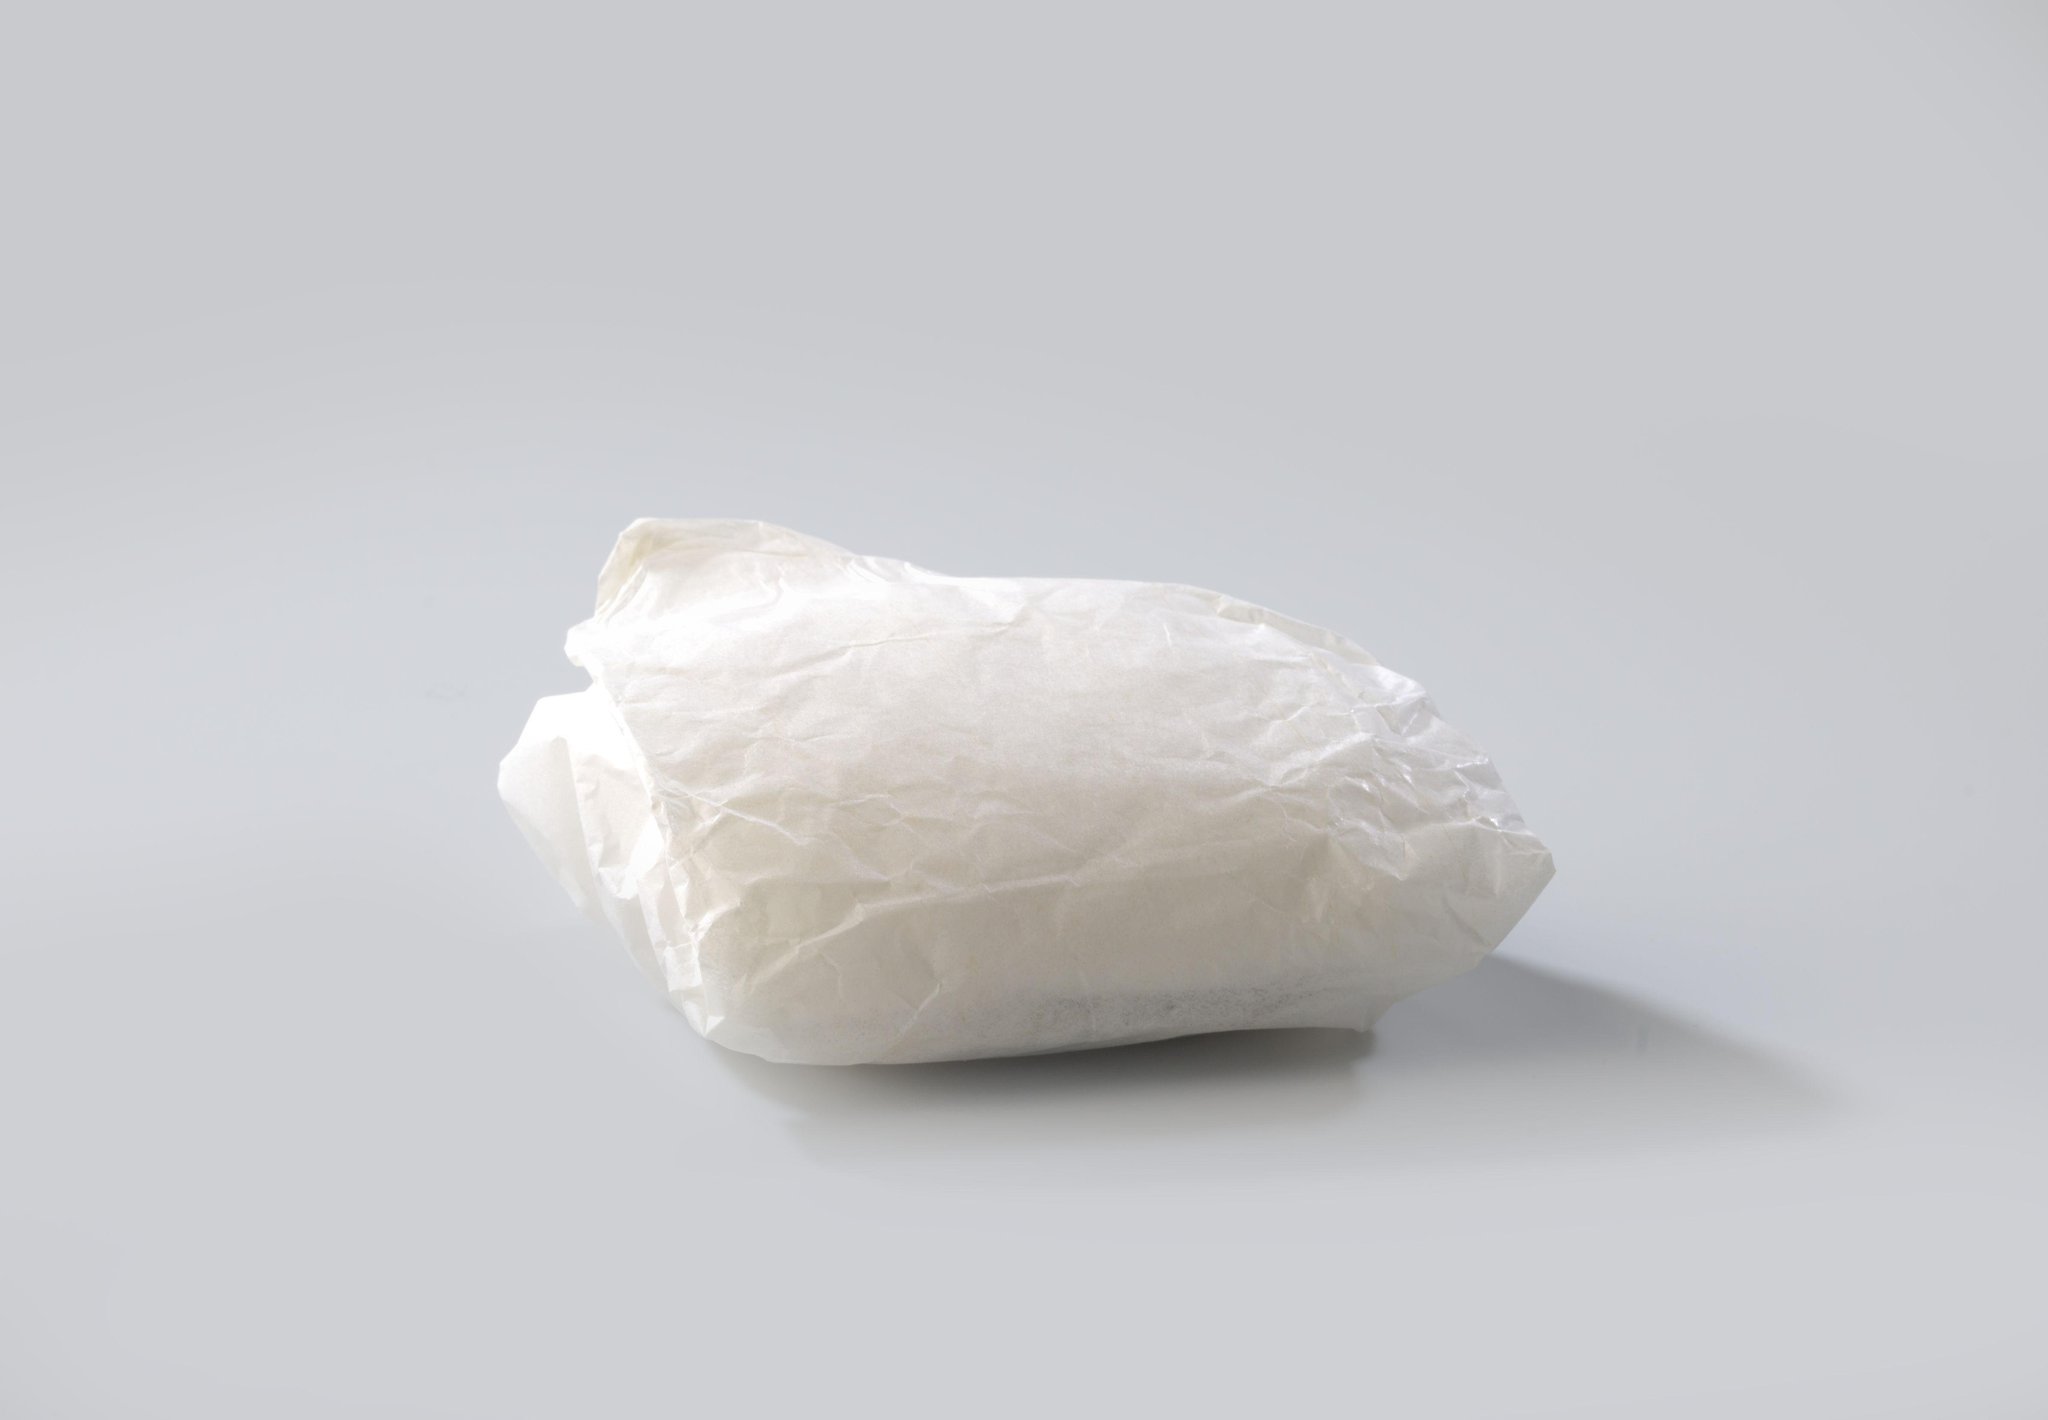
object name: goblet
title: Bokaal, incompleet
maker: Anonymous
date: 1700-1799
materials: glass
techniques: gilding, grinding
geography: germany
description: Incomplete bokaal. Met scherven (BK-NM-10754-119-1-1). Met bijbehorende deksel (BK-NM-10754-119-2).